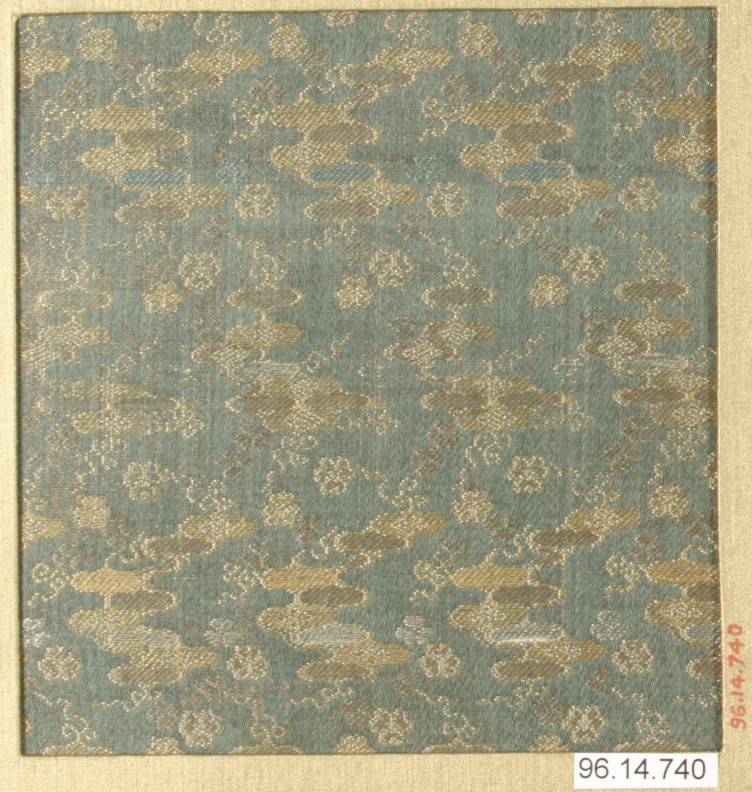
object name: piece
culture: japanese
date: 1701-1900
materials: silk